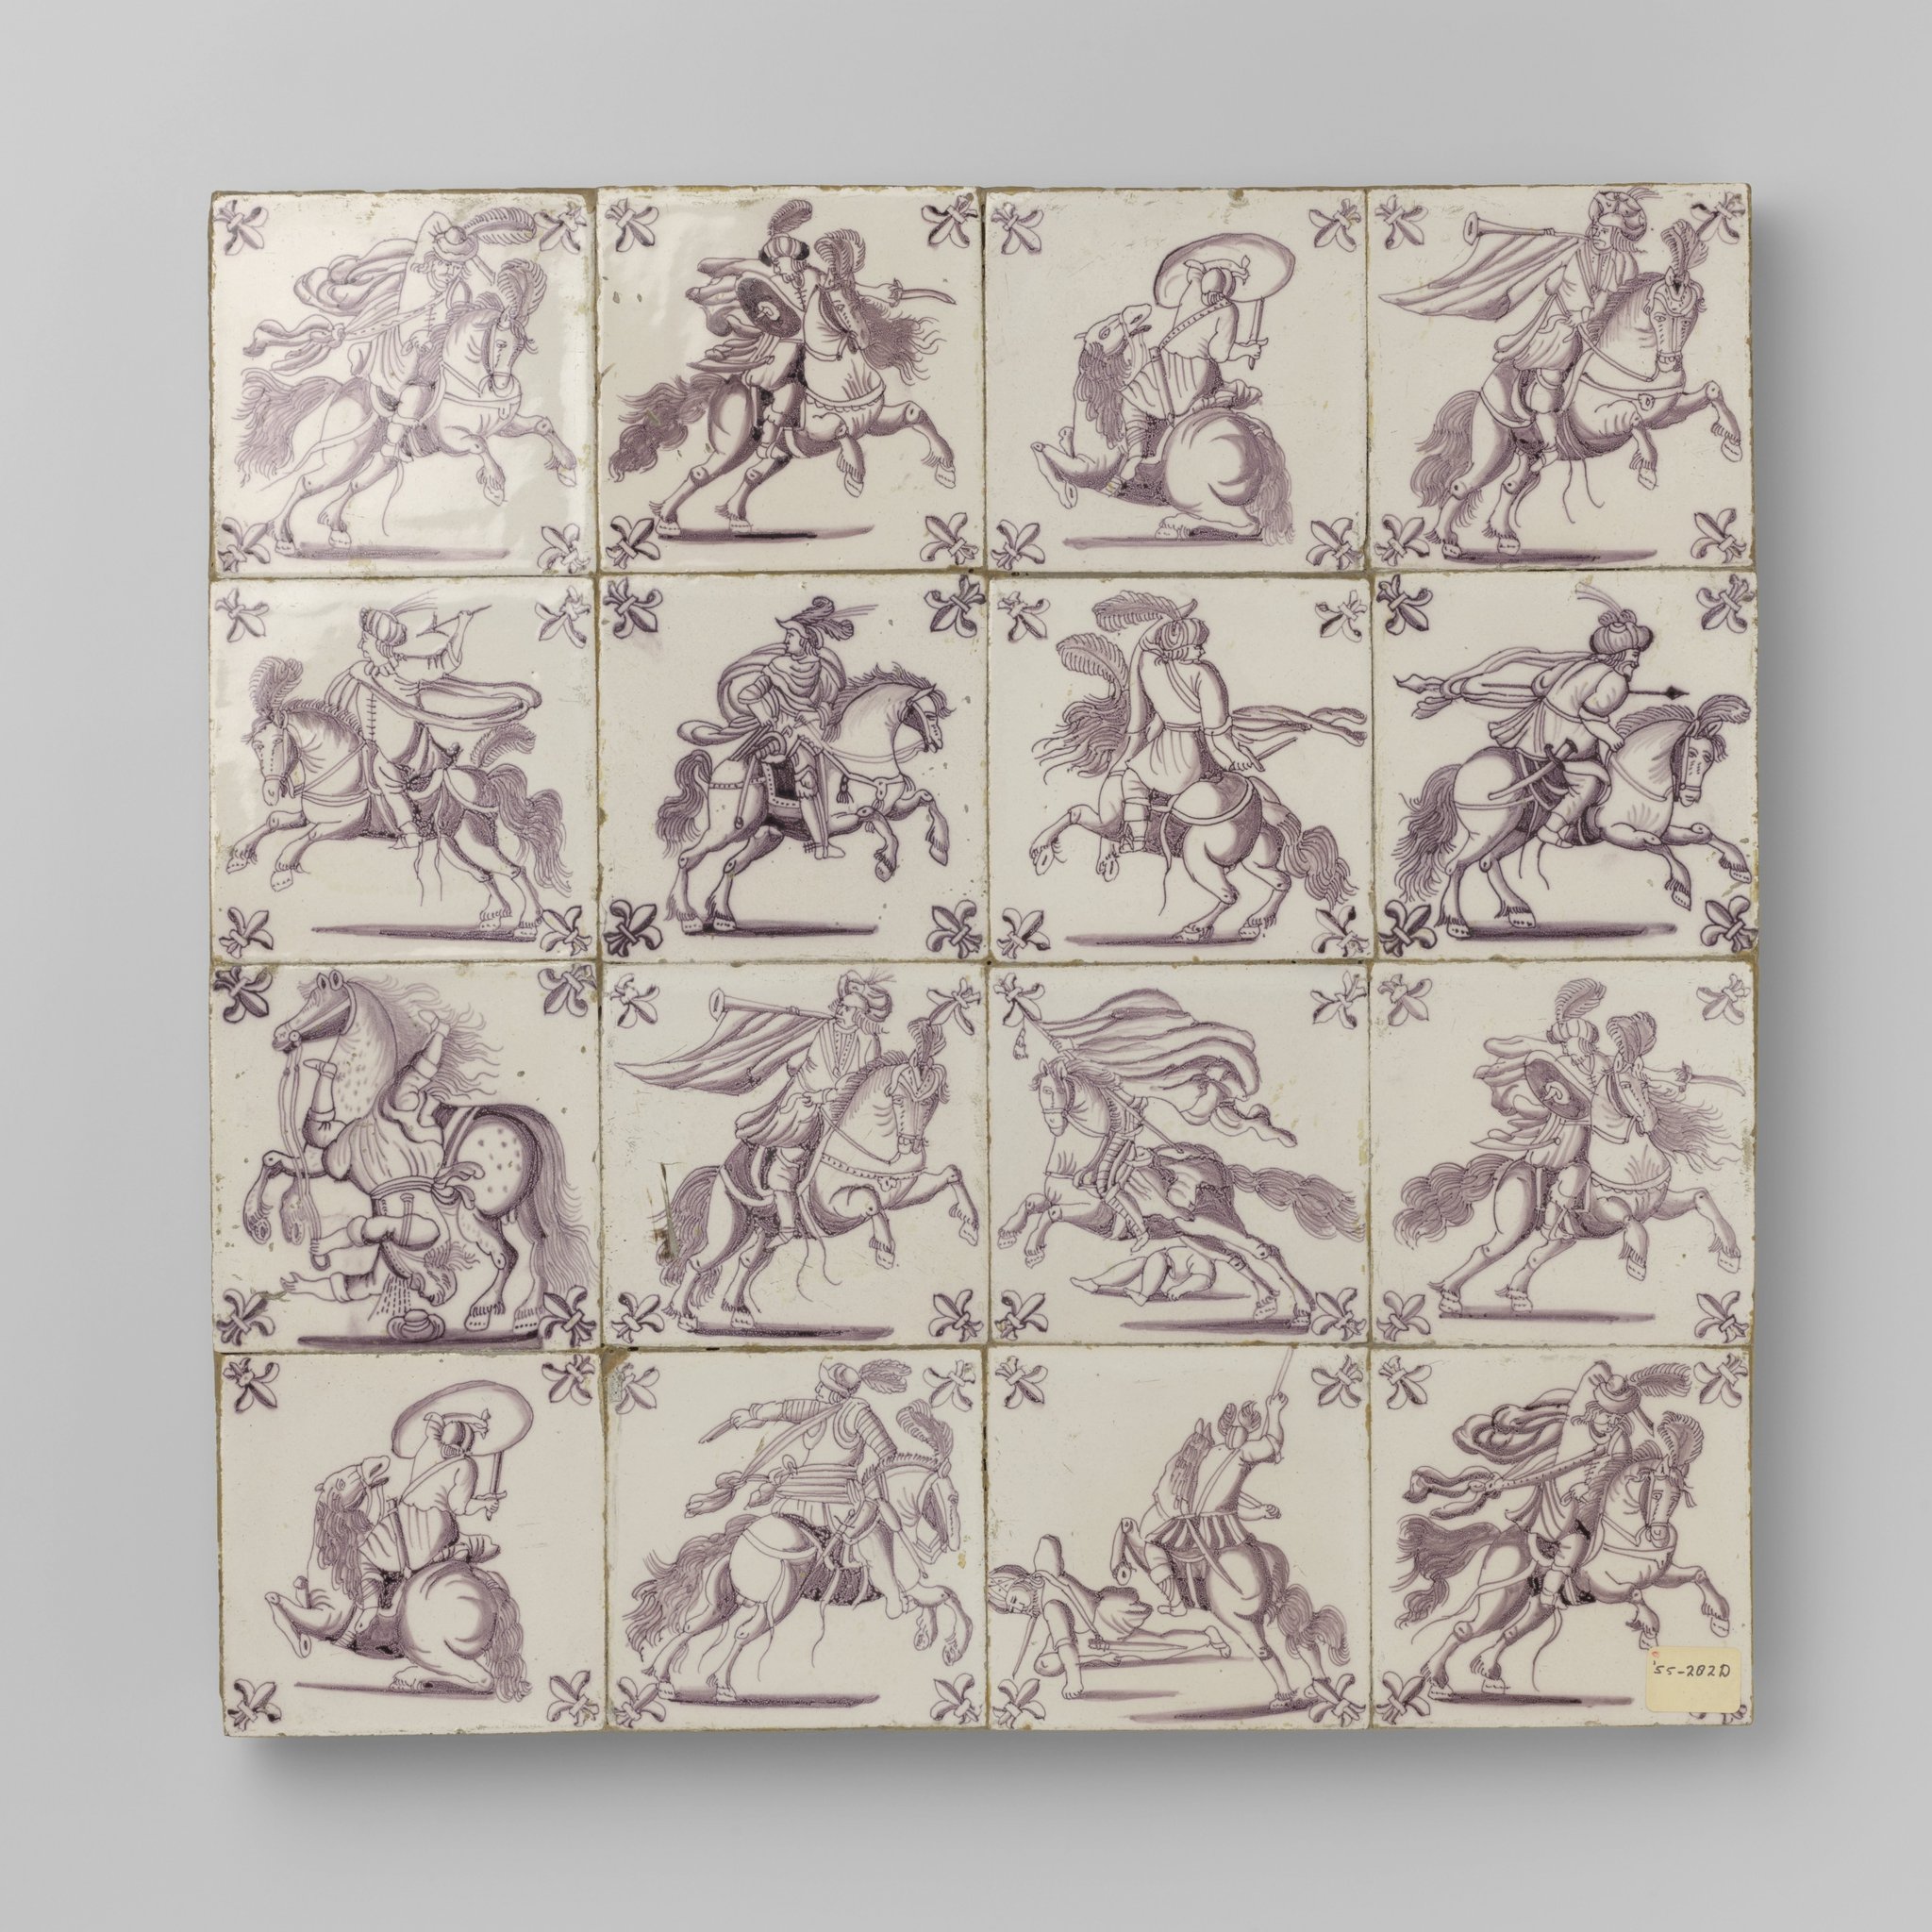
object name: ruitertegel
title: Veld van zestien tegels met ruiters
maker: Anonymous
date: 1700-1750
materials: earthenware, glaze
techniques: maiolica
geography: netherlands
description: Veld van zestien tegels (4 x 4) elk met een paars geschilderde ruiter met in de hoeken, een lelie.